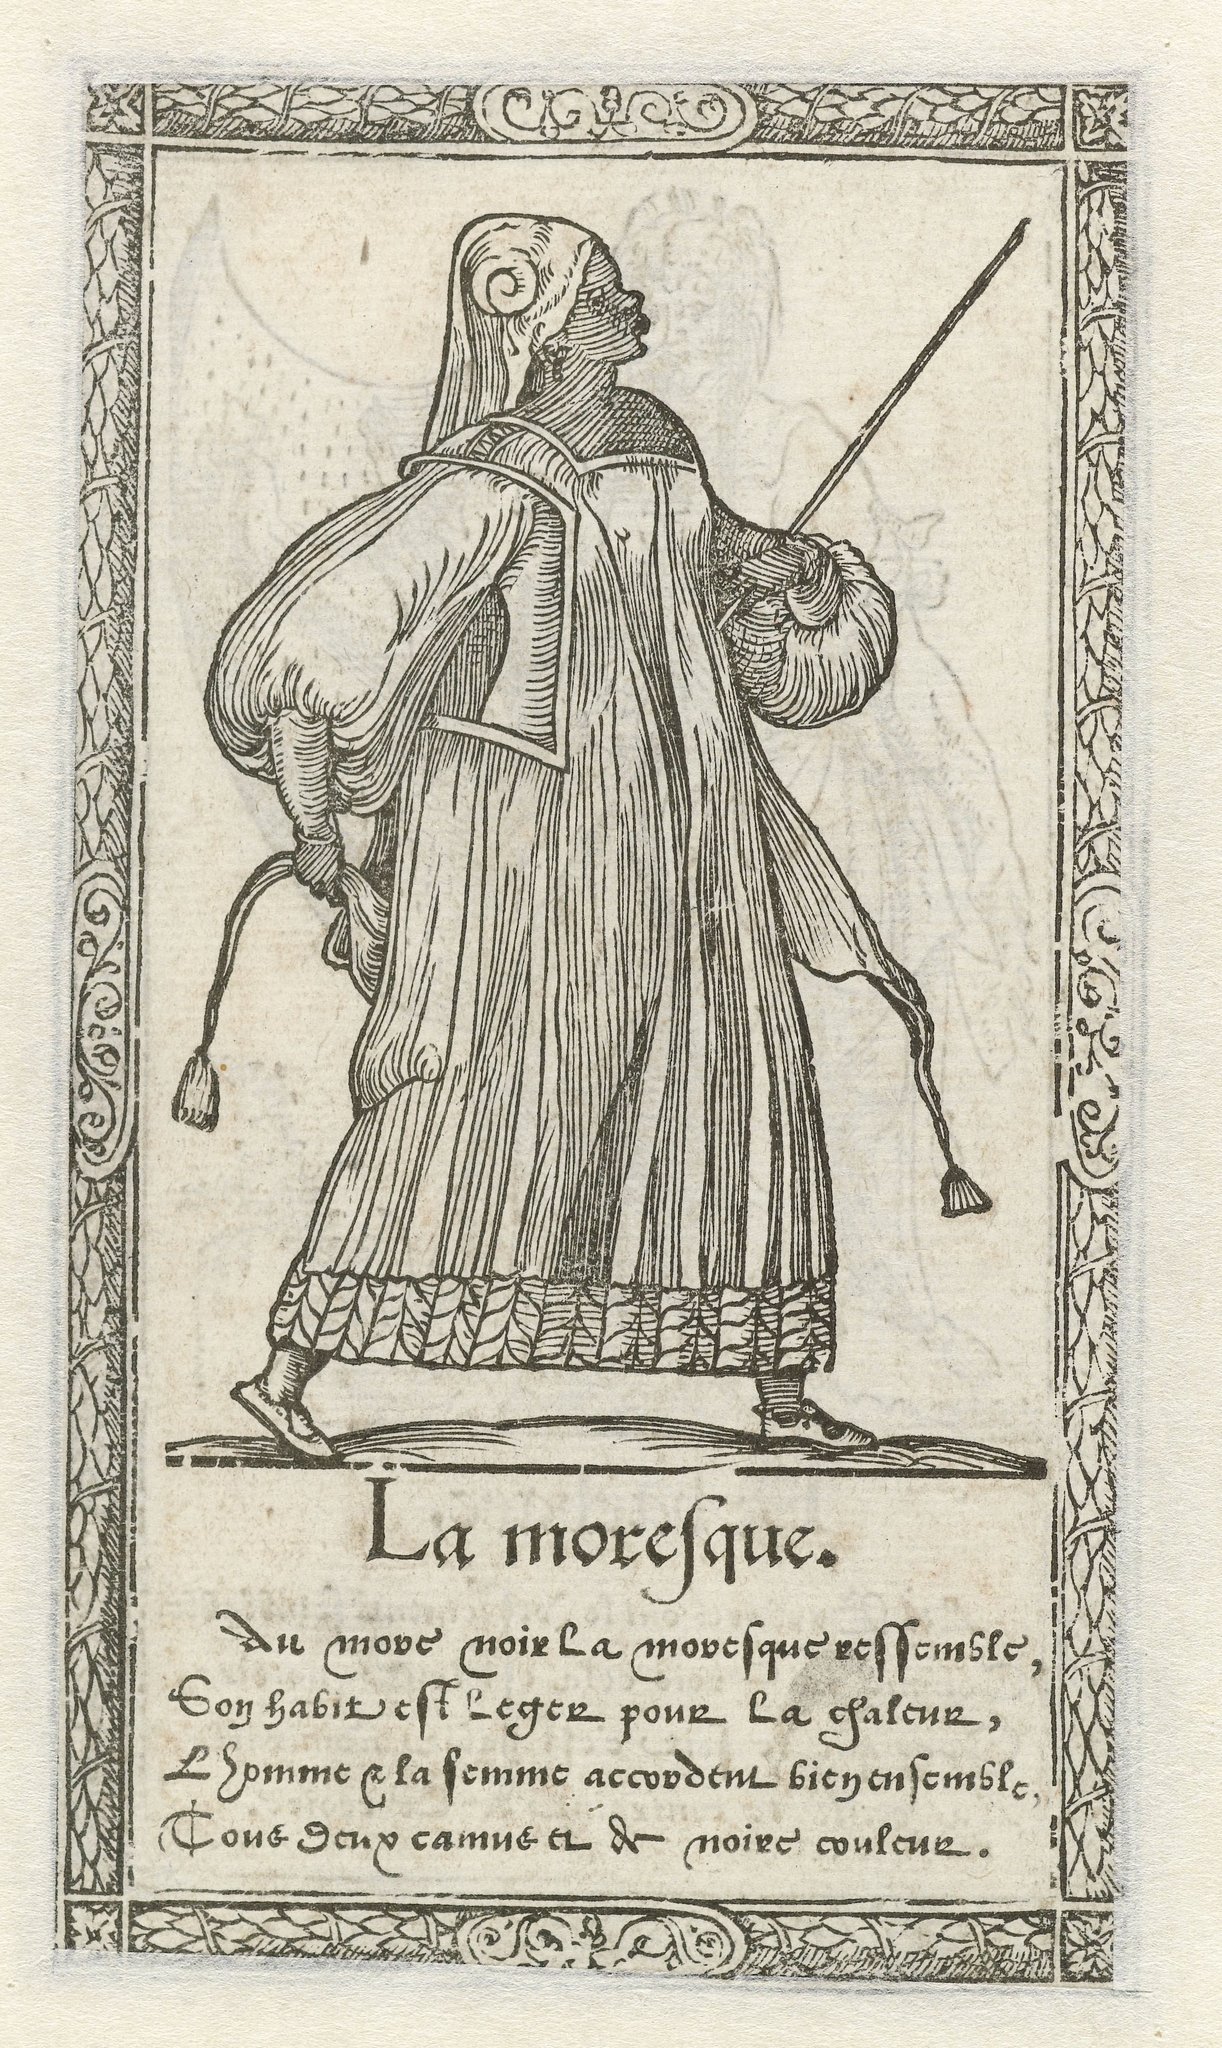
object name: print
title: Recueil de la diversité des habits (A Collection of the Various Styles of Clothing)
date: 1562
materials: paper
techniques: woodcut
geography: paris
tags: africans (+ costume), fashion plates, folk costume, regional costume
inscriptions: collector's mark: Lugt 2228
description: This is the very first costume book, with more than a hundred images of clothing from around the world. Below each figure are four lines of verse describing the country’s outfits or related customs. This was an age of unprecedented overseas exploration. Europeans were especially fascinated to see and read about inhabitants of the so-called New World, such as the Brazilian woman with her child 1.